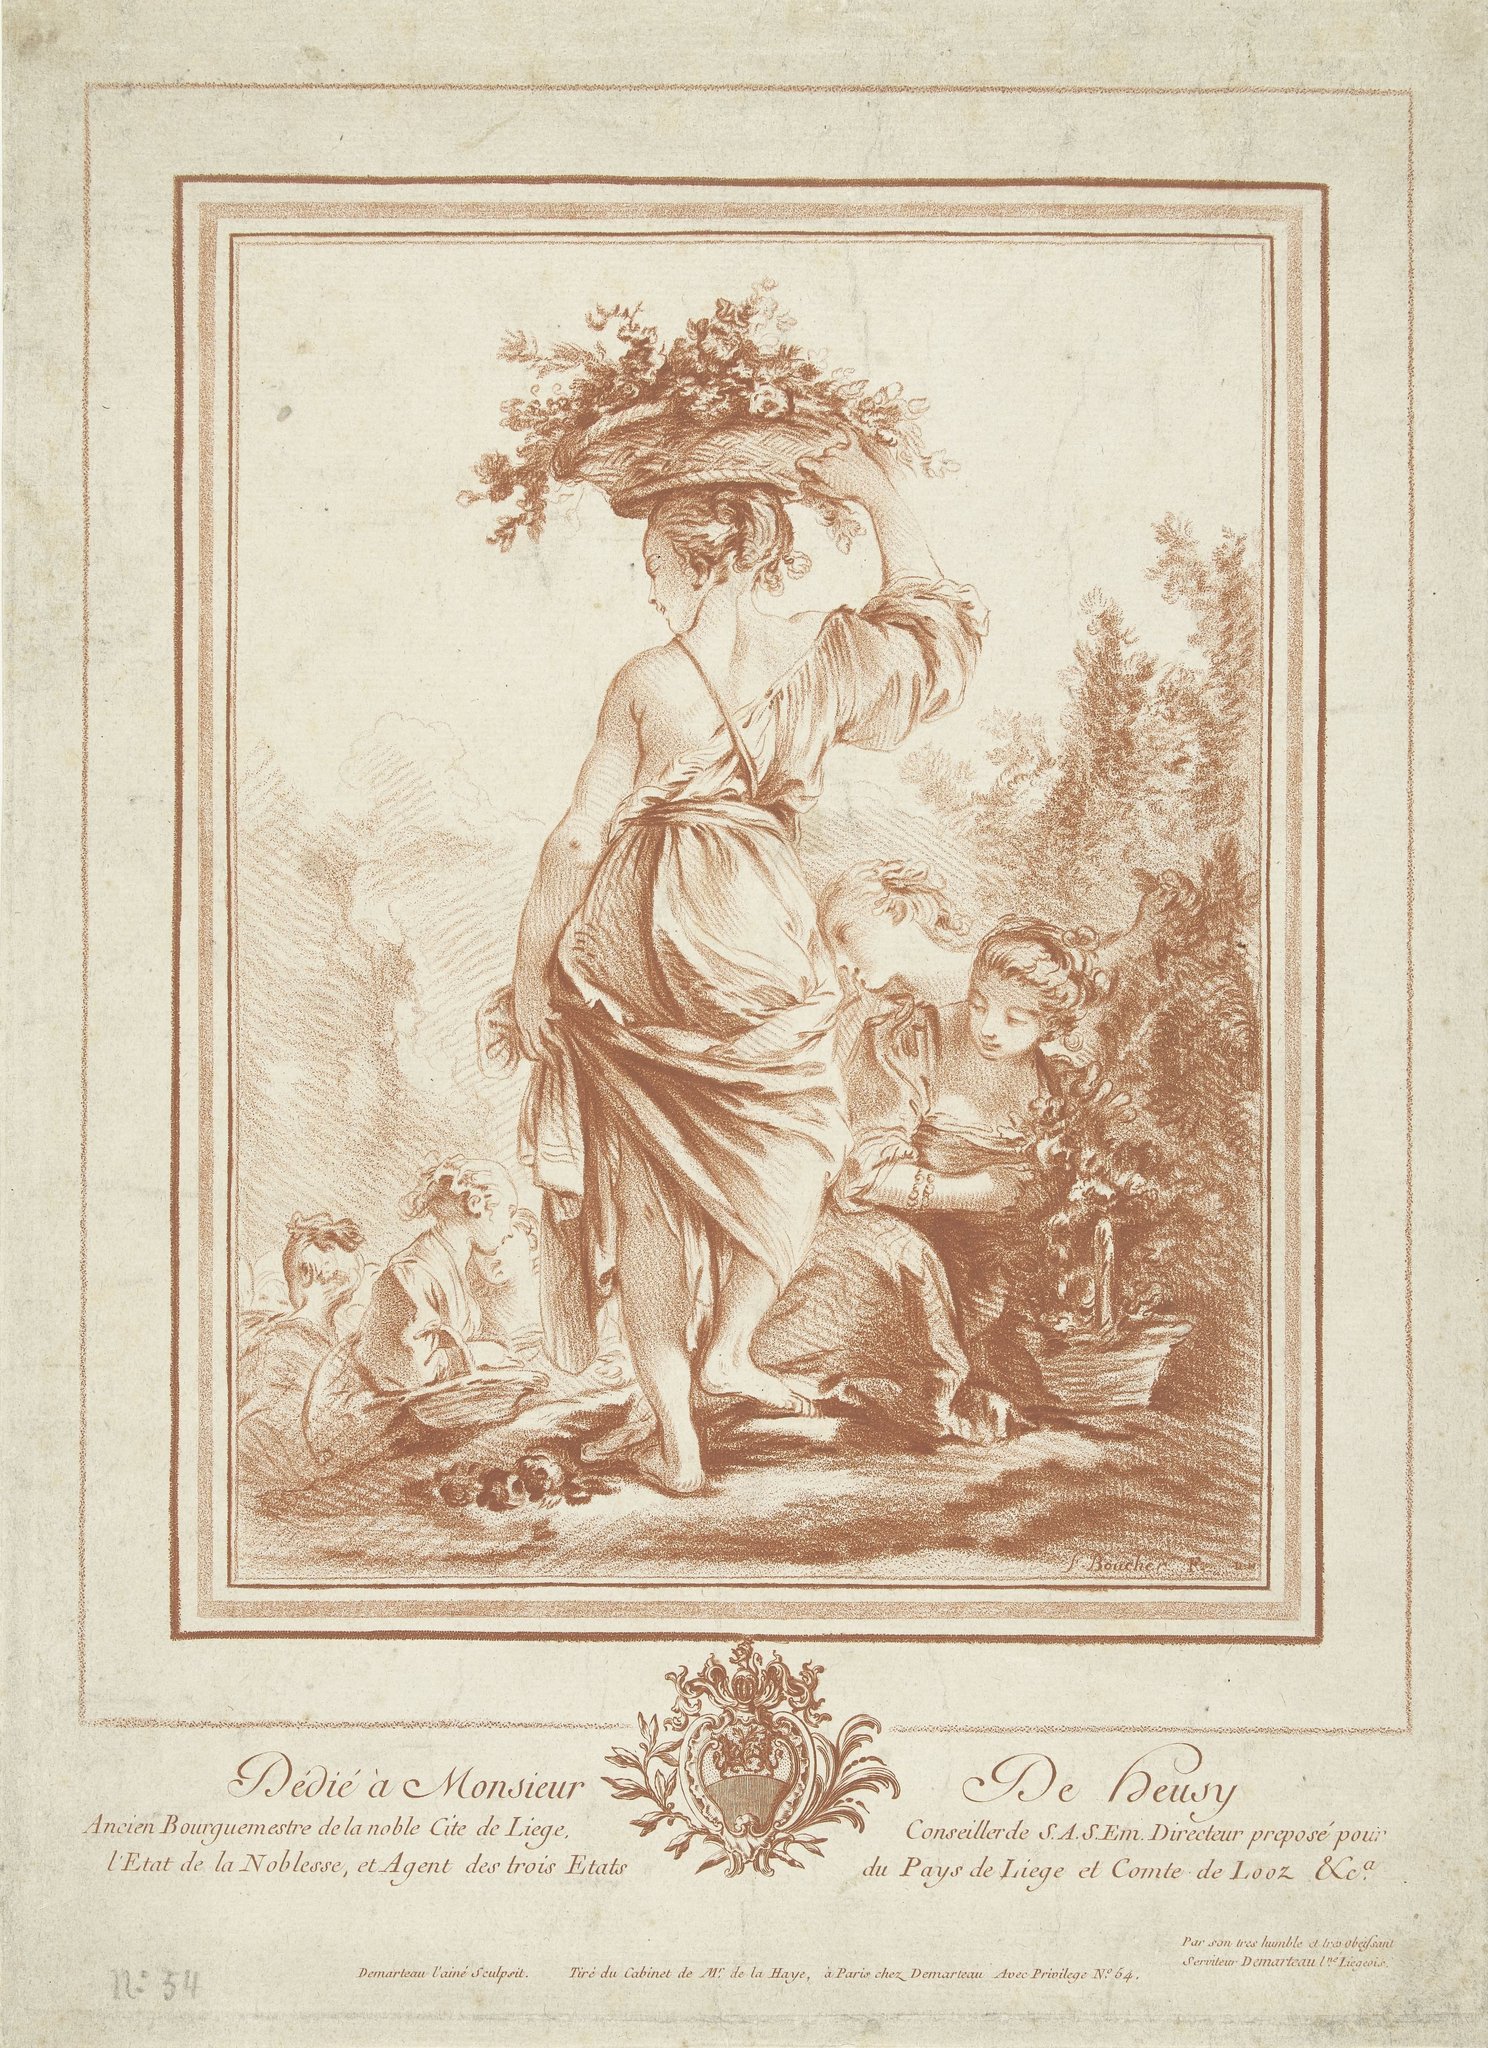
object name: print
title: Vrouw met bloemenmand in tuin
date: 1732-1776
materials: paper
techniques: printmaking, etching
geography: paris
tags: gardening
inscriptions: collector's mark: Lugt 2228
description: Vrouw met bloemenmand in tuin, bij struiken plukken andere vrouwen bloemen.